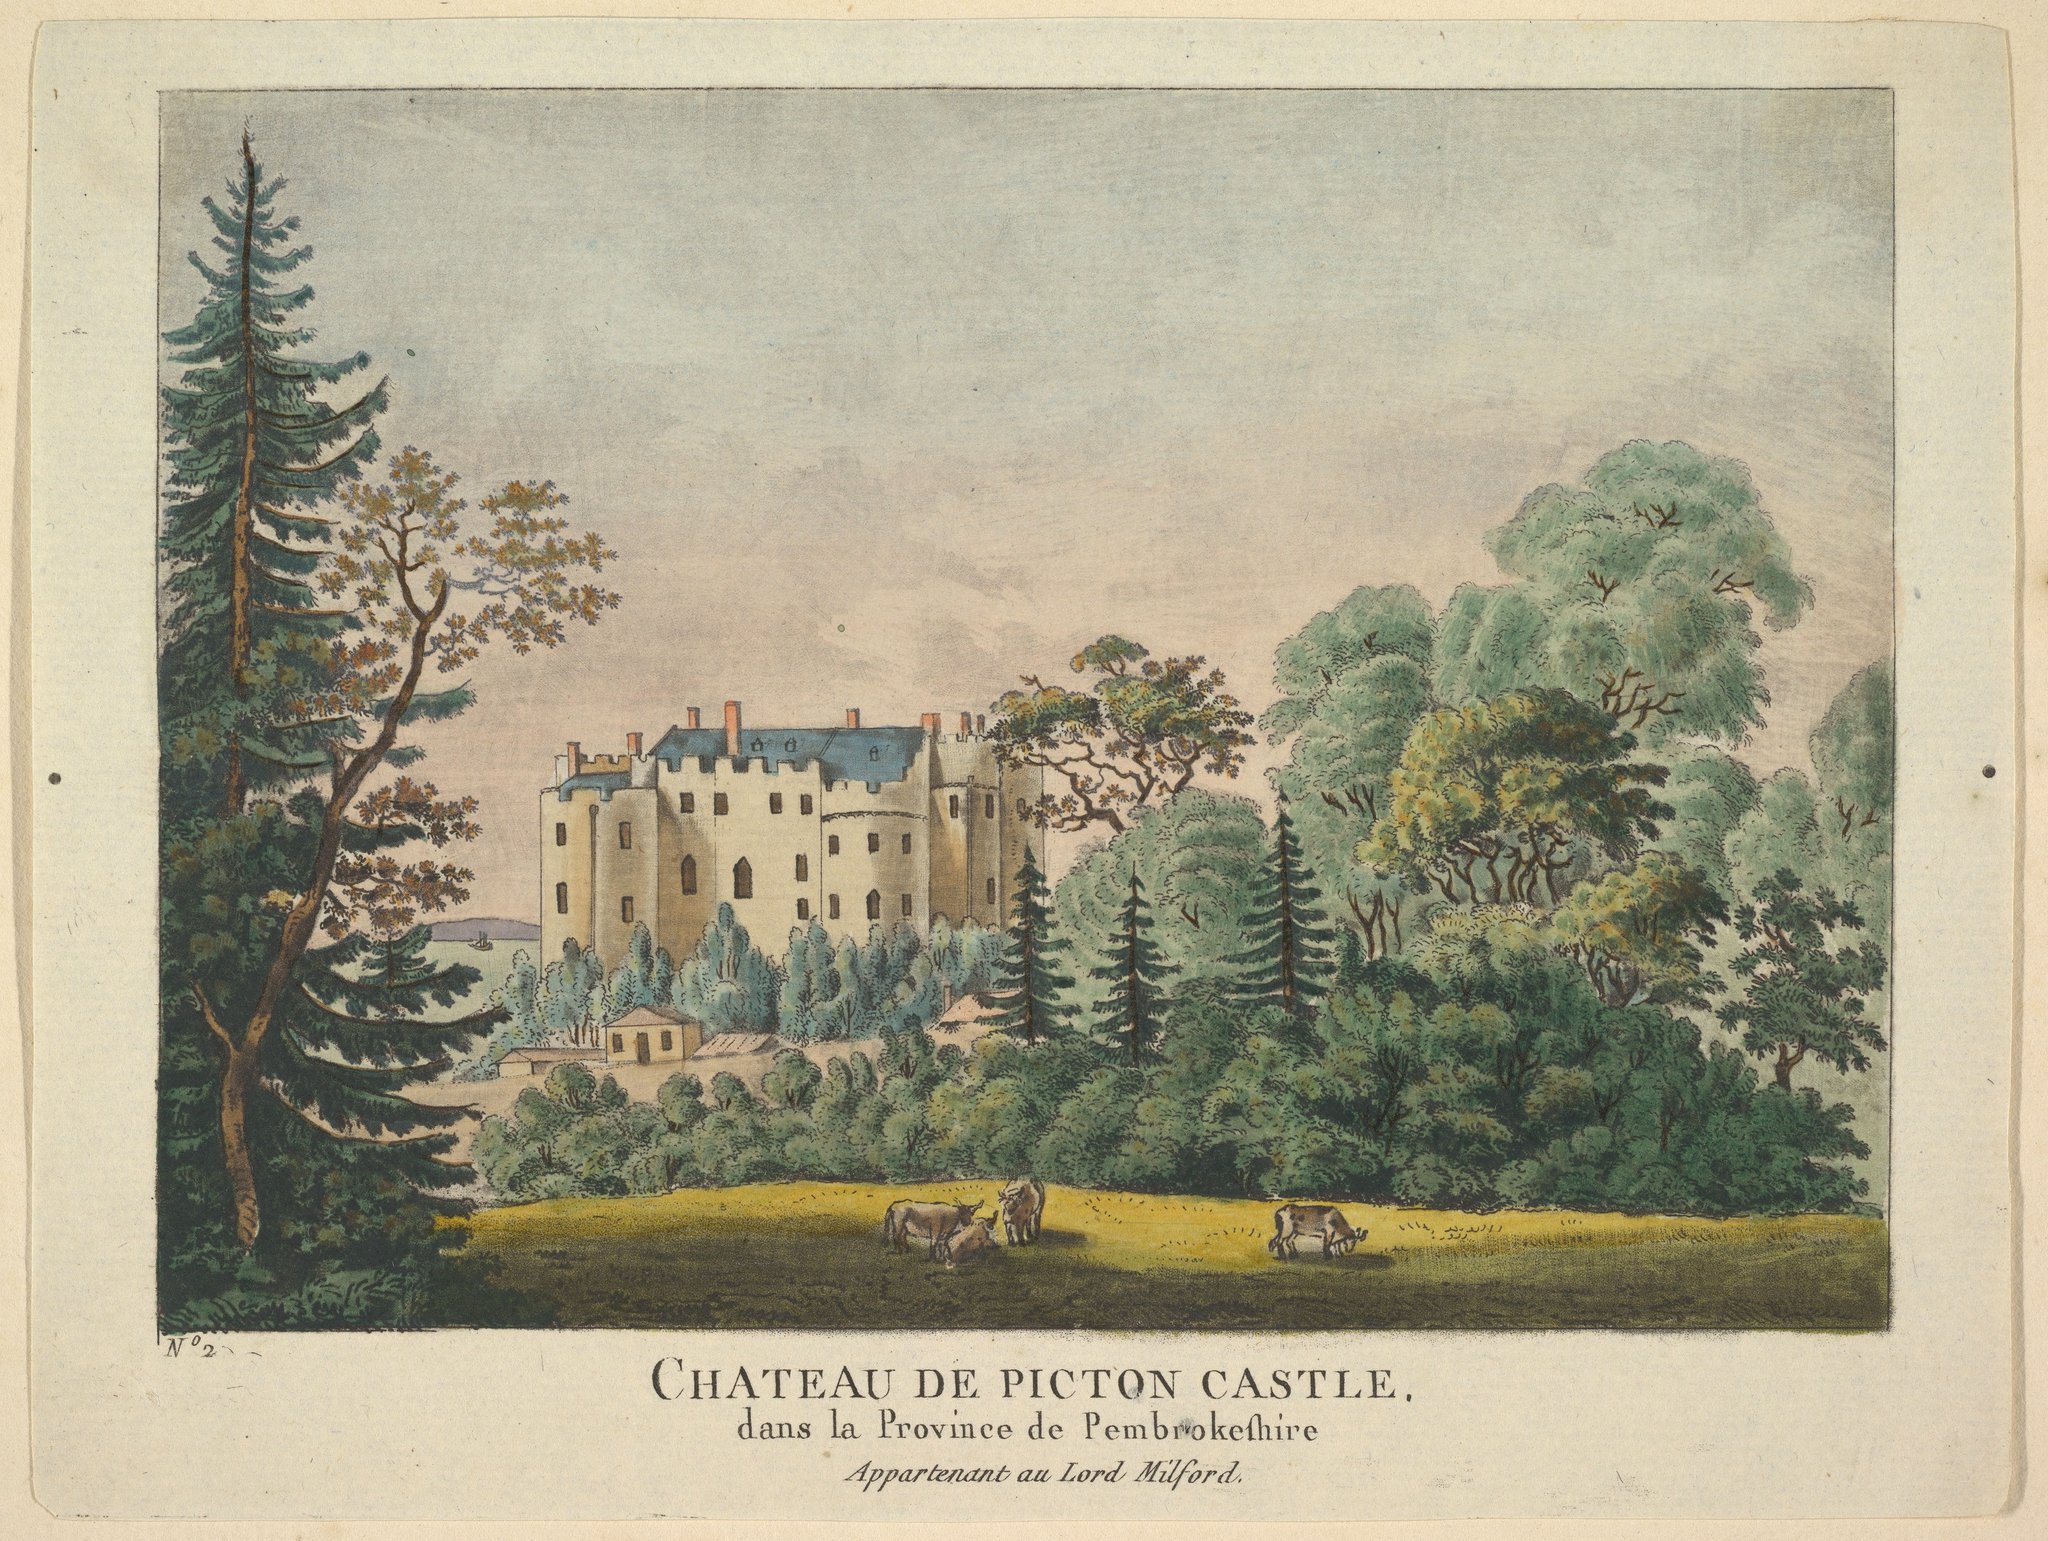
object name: print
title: Château de Picton Castle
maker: anonymous, french, 18th century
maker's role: artist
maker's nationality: french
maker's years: 1700-1800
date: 1735-1743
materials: watercolor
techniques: etching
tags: animals,castles,trees